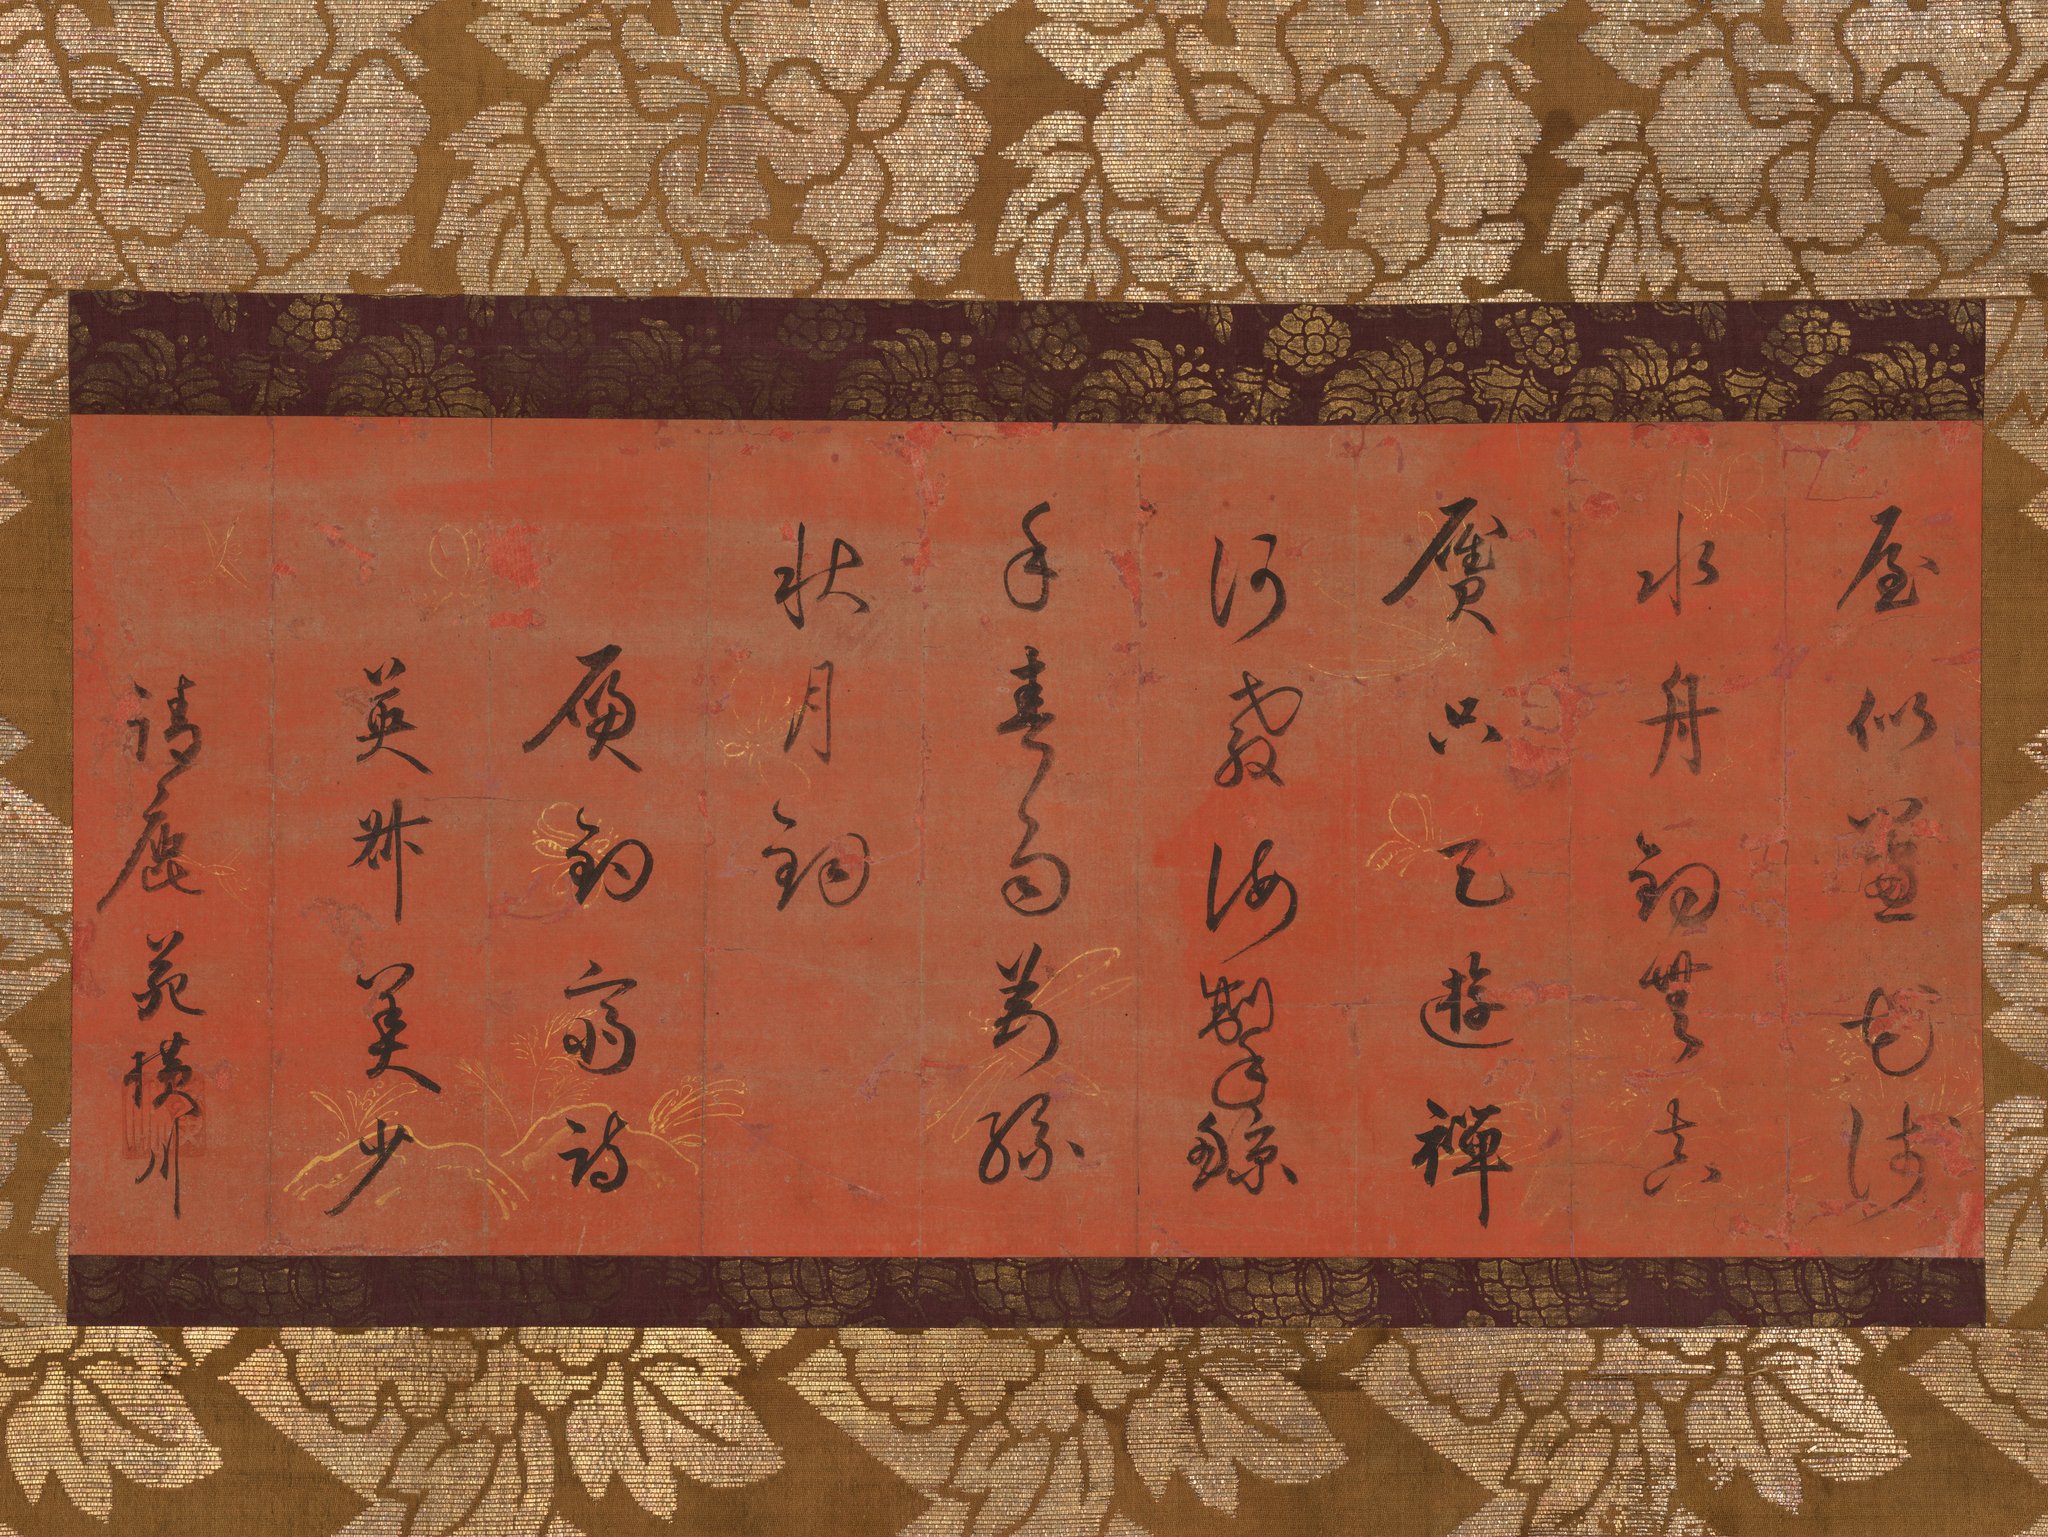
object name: hanging scroll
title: Chinese Poem on Fishing and Zen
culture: japanese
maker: ōsen keisan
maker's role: artist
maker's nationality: japanese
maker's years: 1429-1493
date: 1467-1500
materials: gold, ink, paper